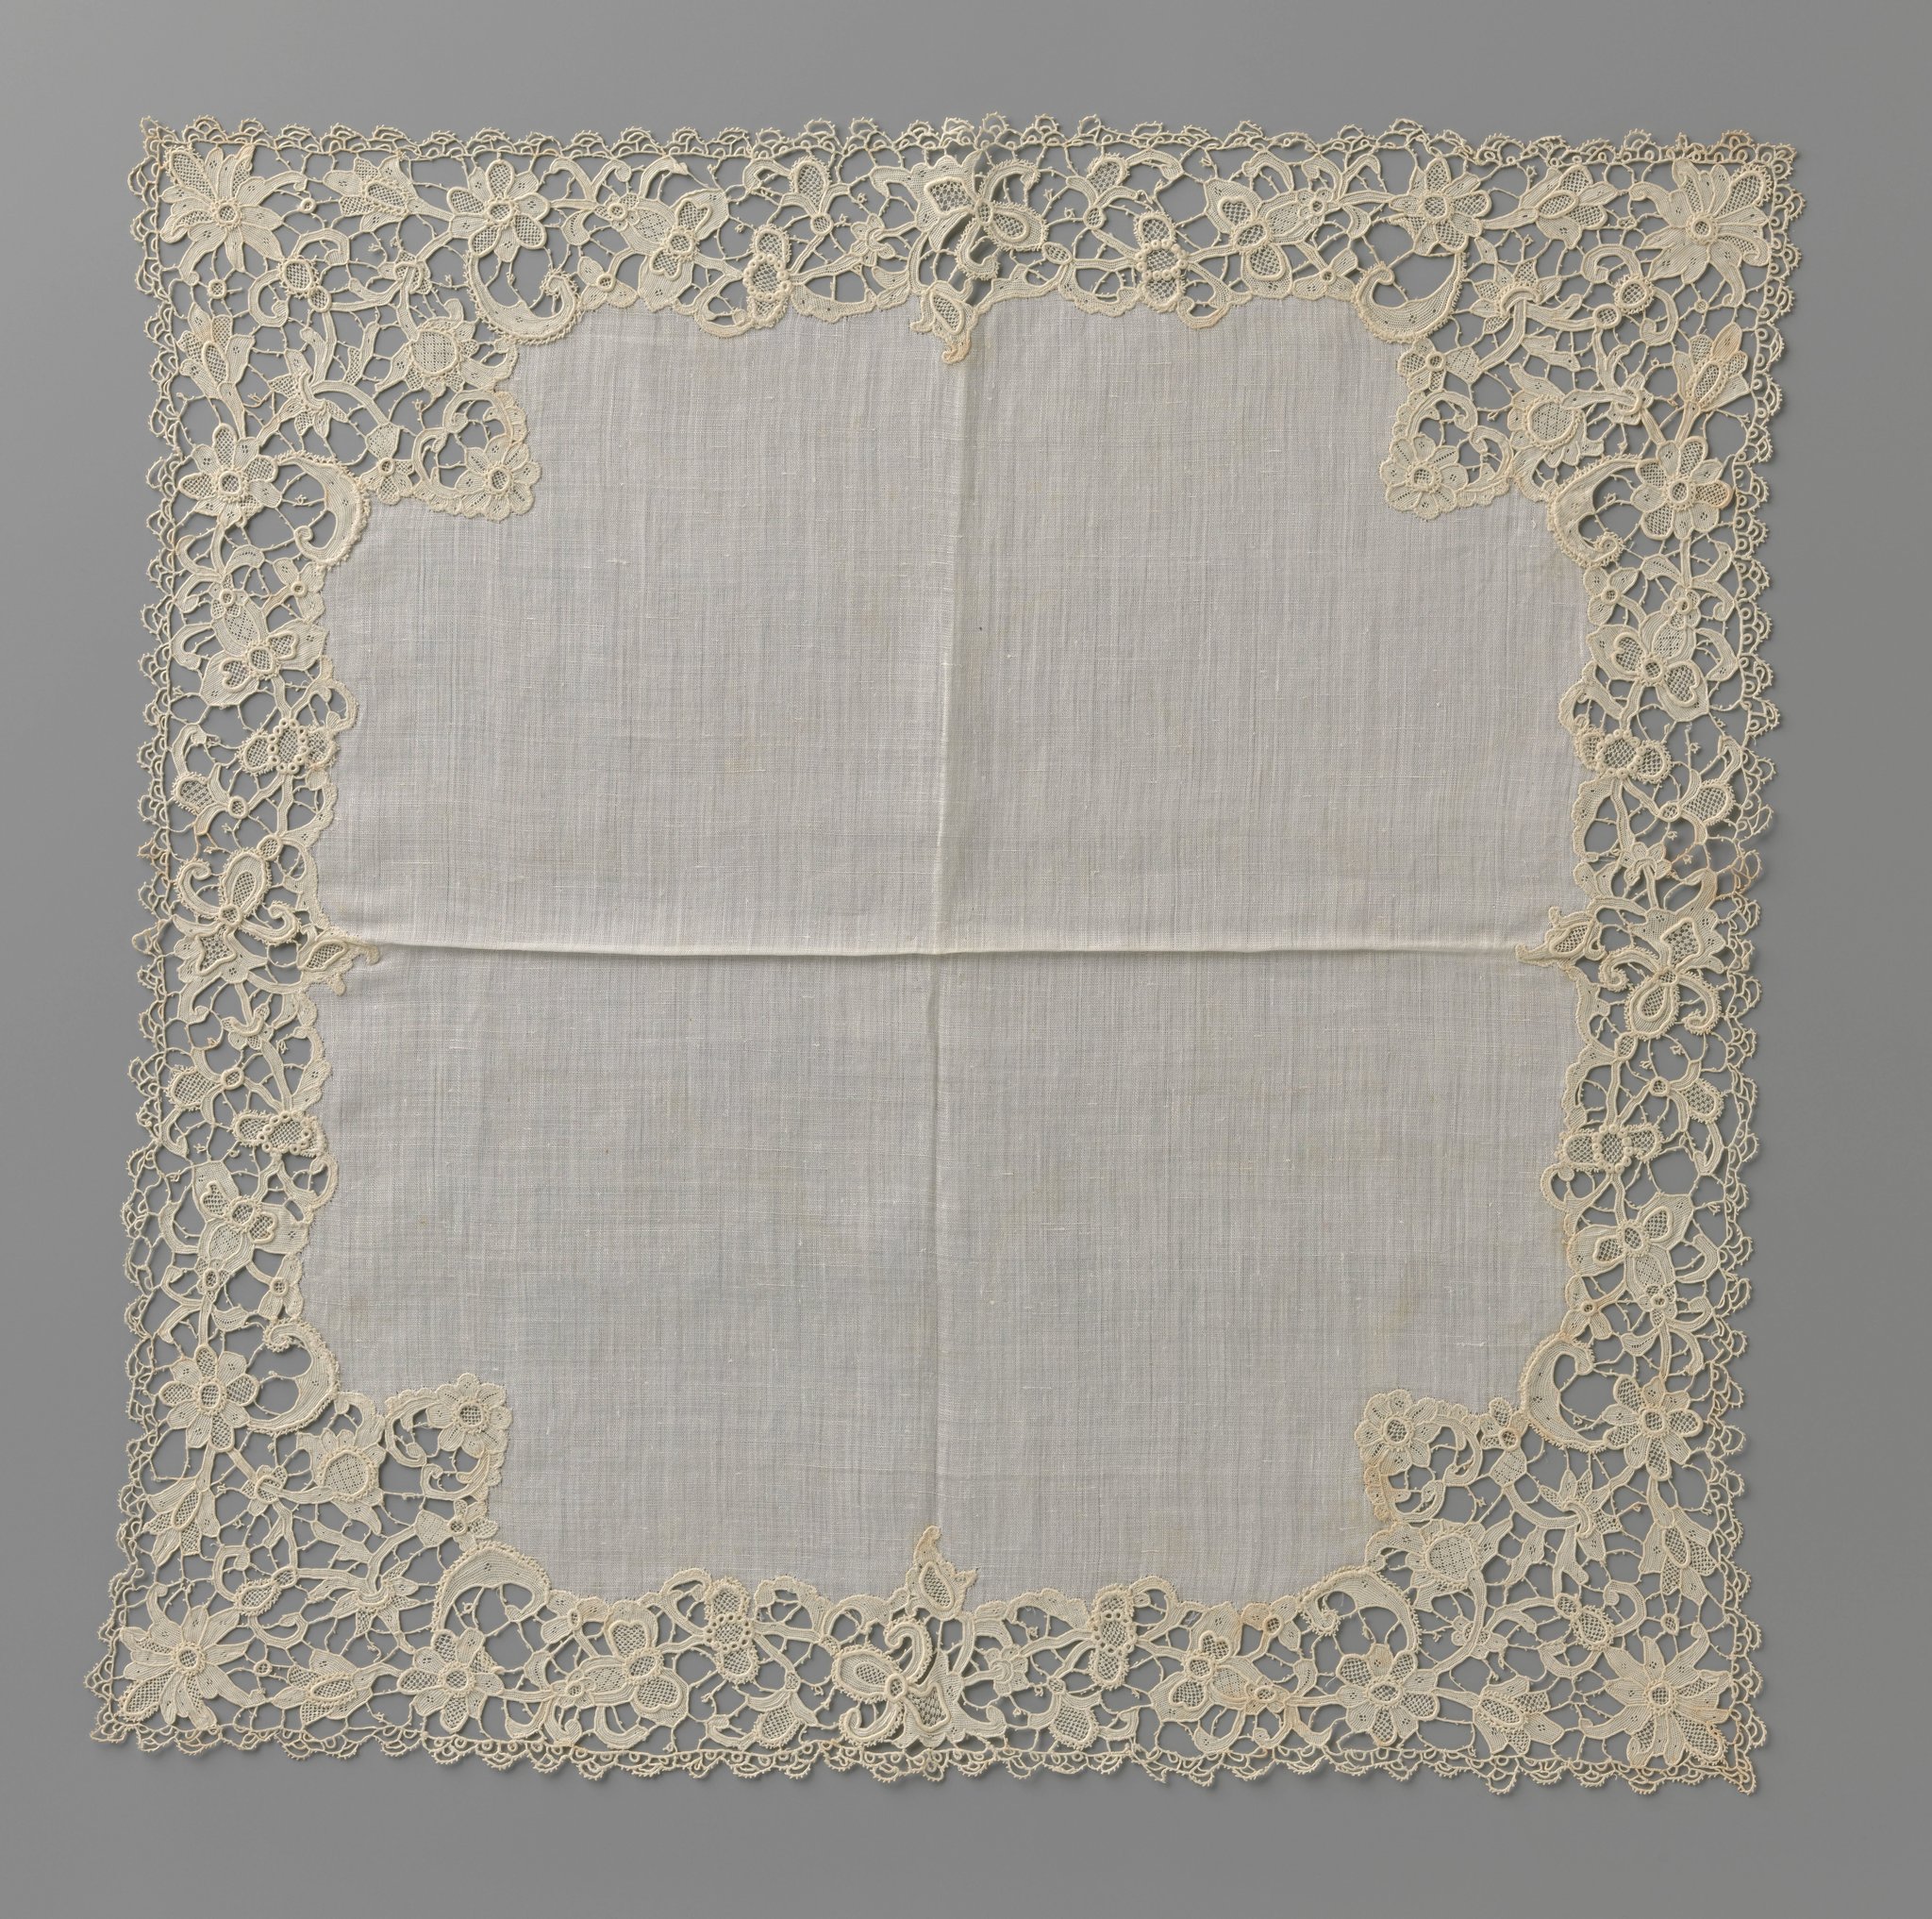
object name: handkerchief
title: Zakdoek van naaldkant met bloemen en een binnenstuk van batist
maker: Anonymous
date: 1870-1909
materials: linen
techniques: embroidery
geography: burano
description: Zakdoek van batist met een rand naturelkleurige naaldkant: Venetiaanse reliëfkant. Het binnenstuk van linnen batist is geschulpt. Op een spijlengrond staan ranken met veelsoortige bloemen, zoals waaiervormige palmetbloemen, paisley motieven, enzovoort, die asymmetrisch zijn gegroepeerd.